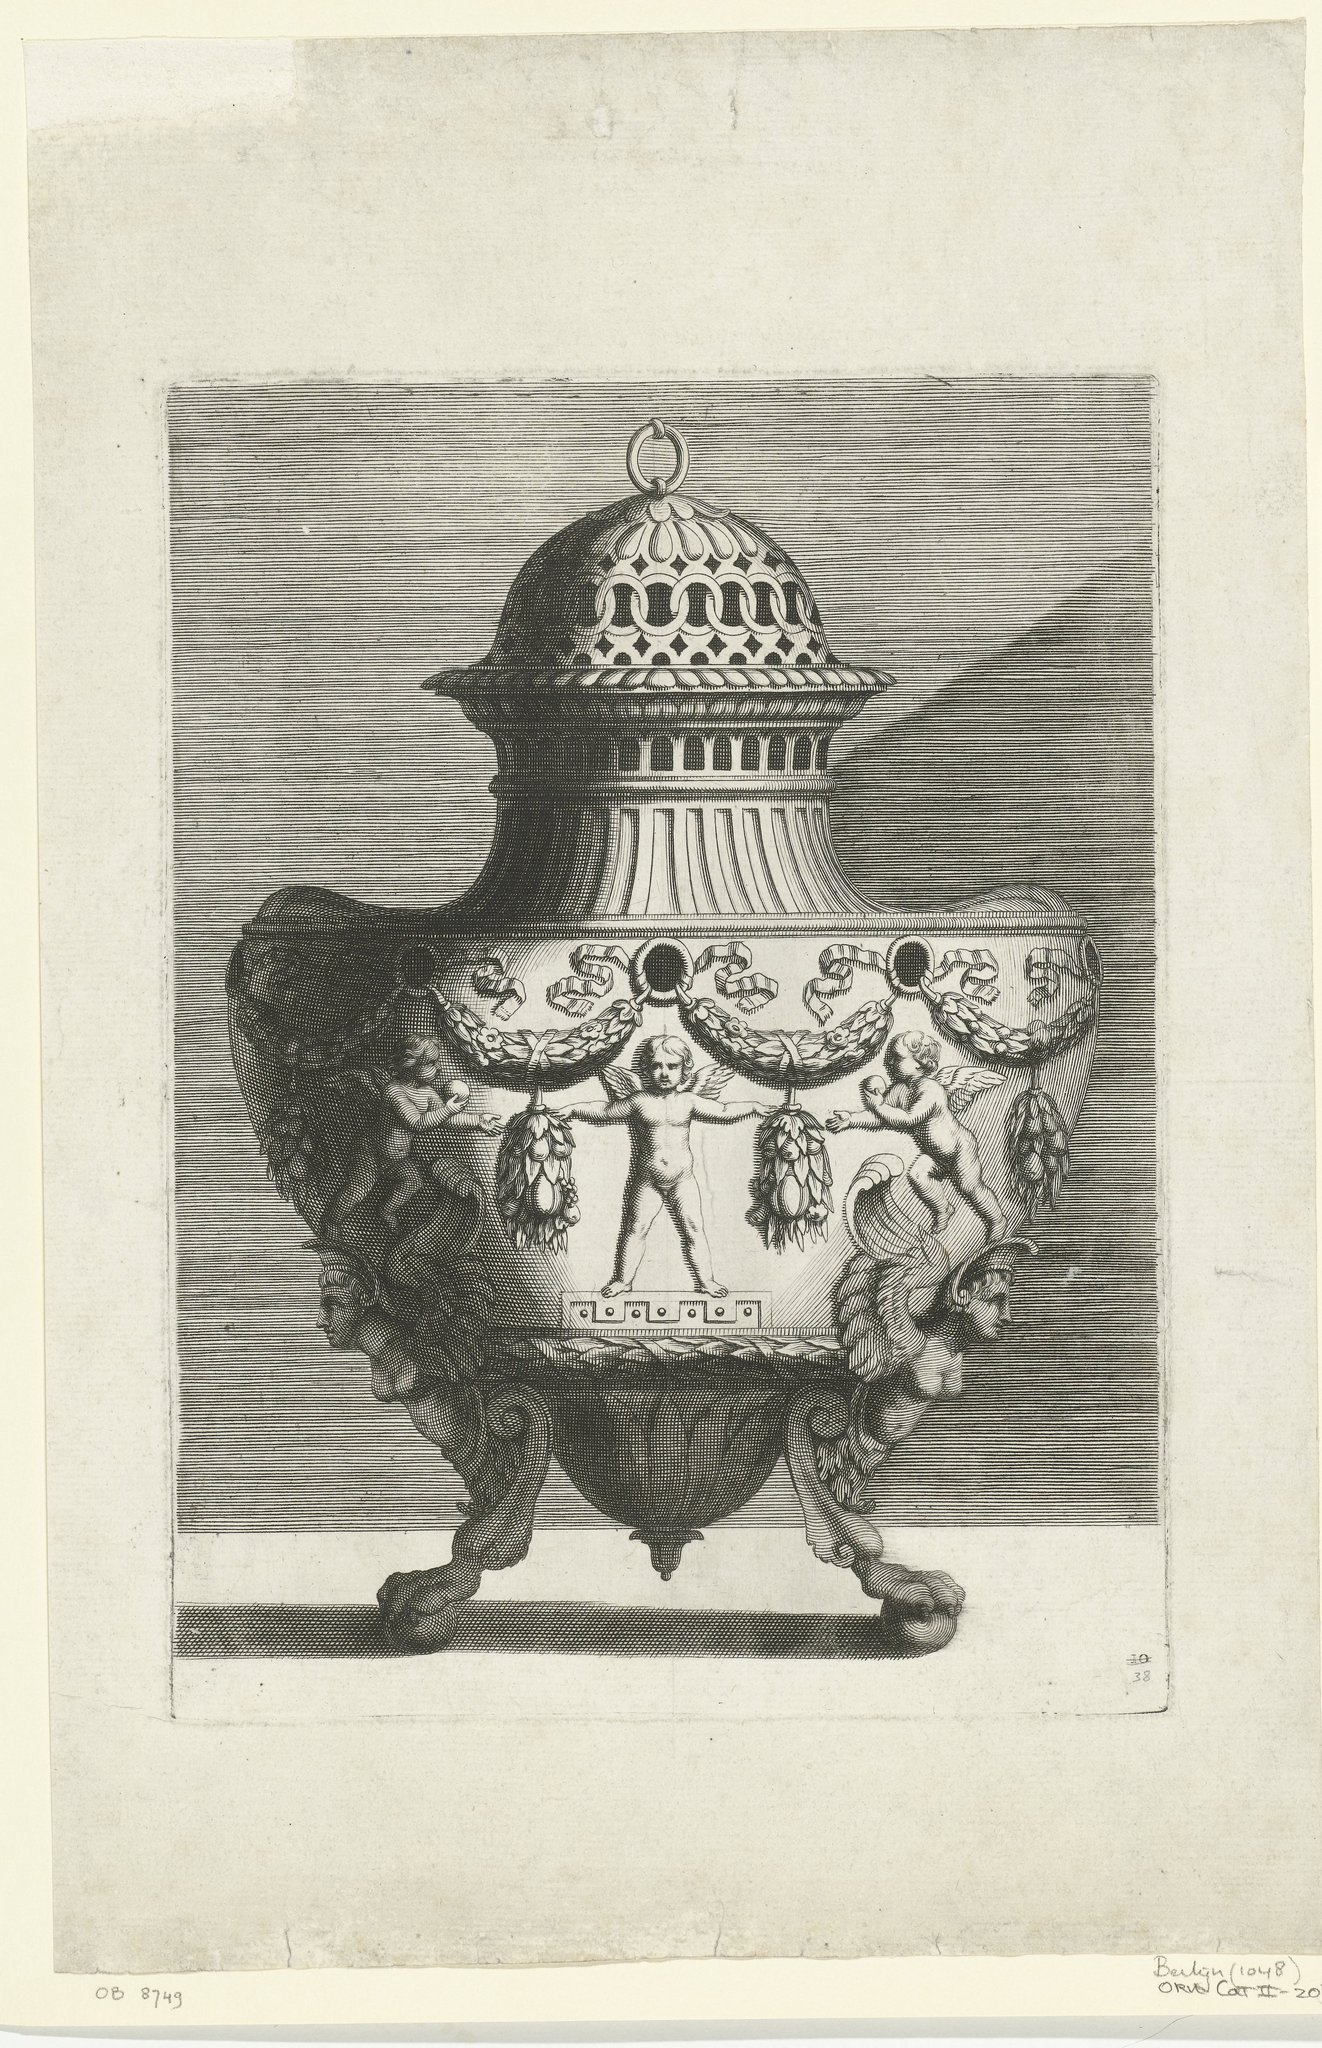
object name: ornament print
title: Second Livre de Vases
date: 1667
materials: paper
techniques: engraving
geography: france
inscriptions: number: ‘38’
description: Het lichaam is gedecoreerd met guirlandes, festoenen en putti. Rechtsonder: 10, dit blad behoorde oorspronkelijk tot de eerste serie van de vazen, nummer 10 (?). Blad 38 uit serie van 25 bladen, genummerd: II (voorheen 26), 27-50.